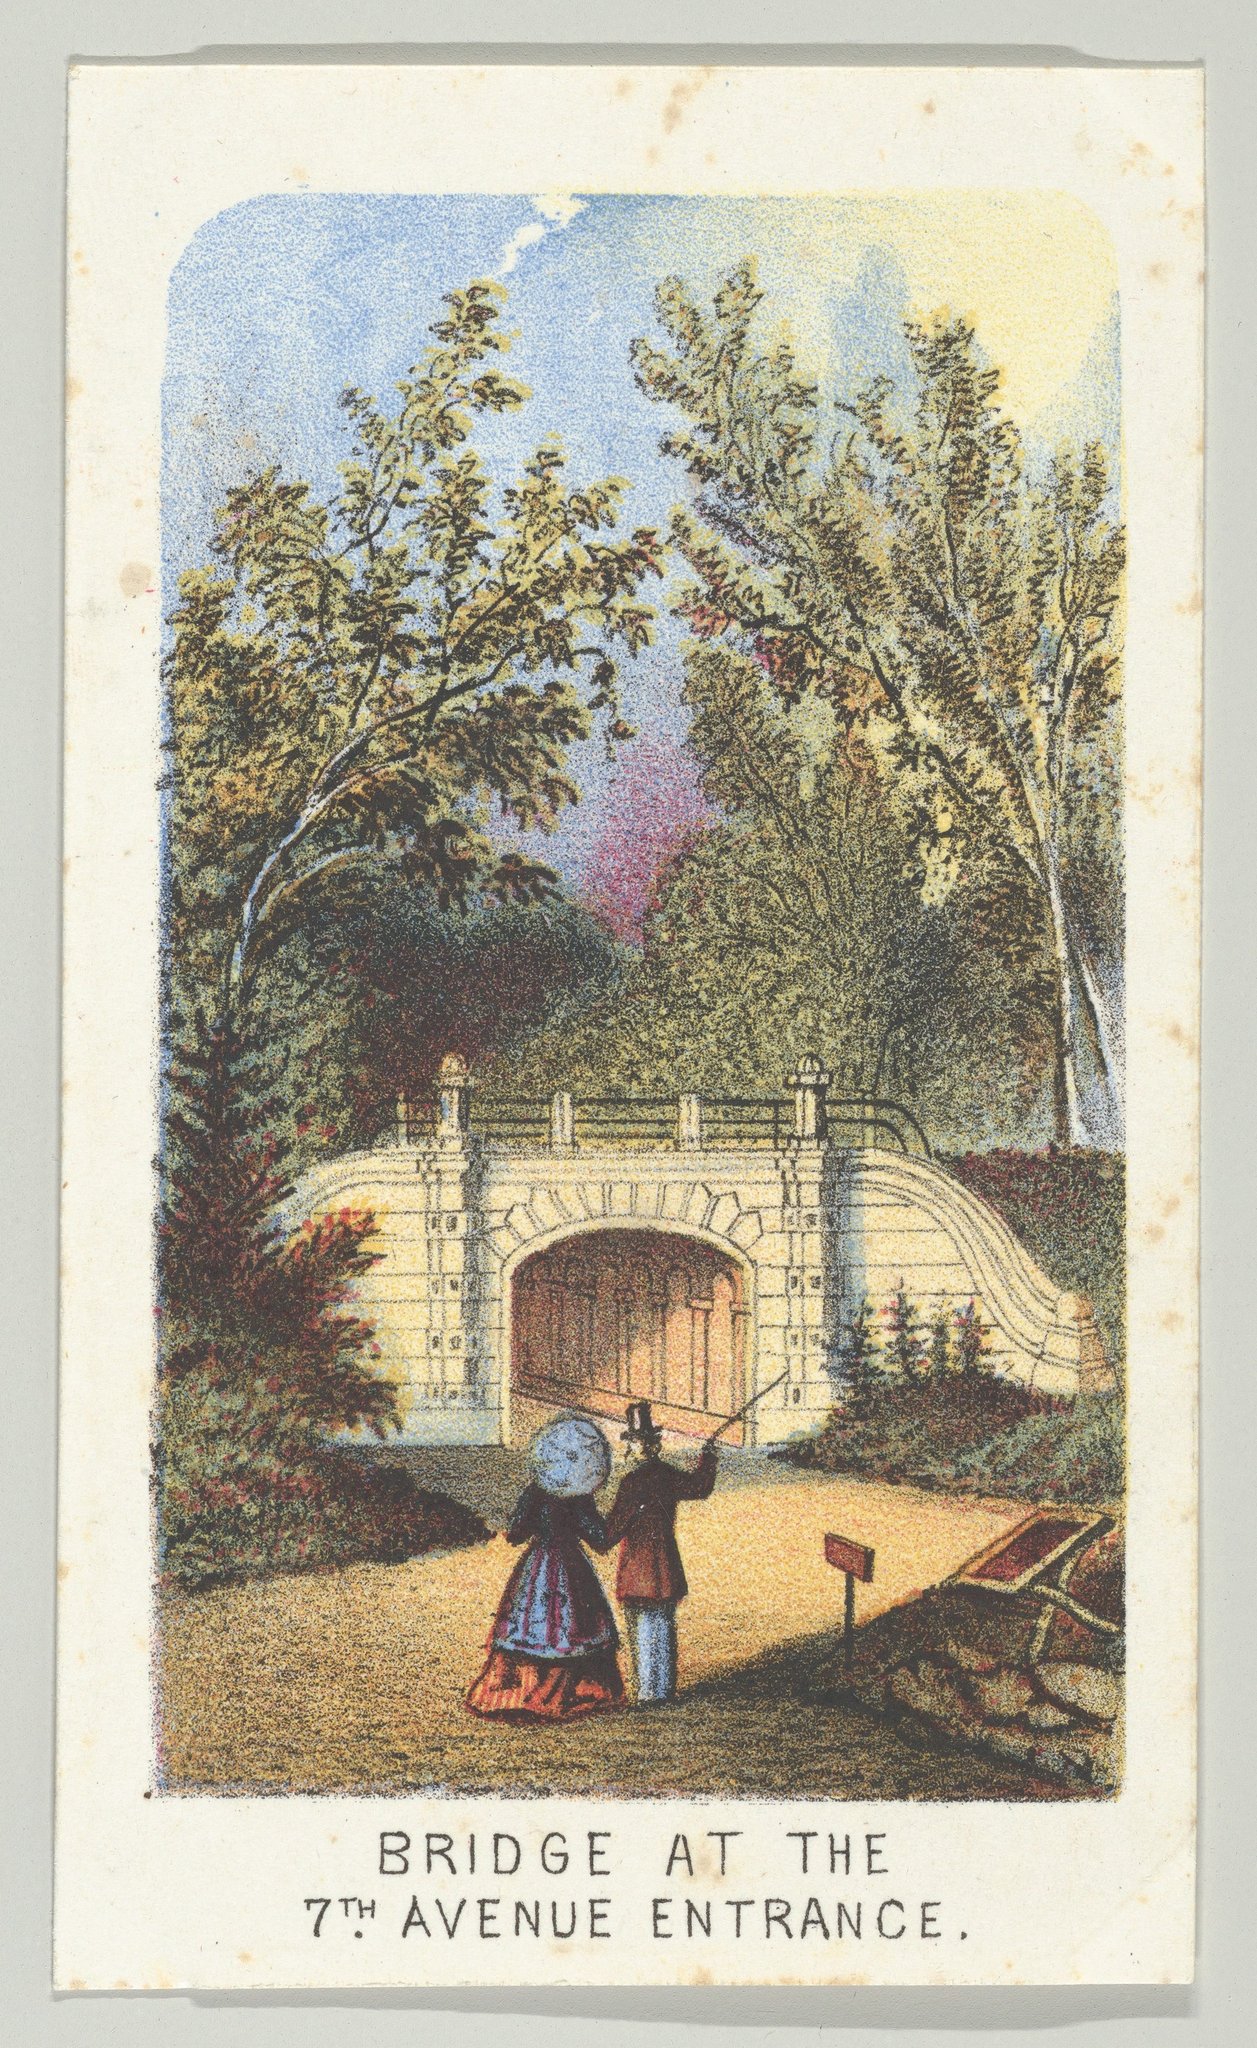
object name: print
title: Bridge at the 7th Avenue Entrance, from the series, Views in Central Park, New York, Part 3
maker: louis prang & co.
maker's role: publisher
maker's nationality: american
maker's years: 1800-1950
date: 1864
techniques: lithograph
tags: bridges,men,women